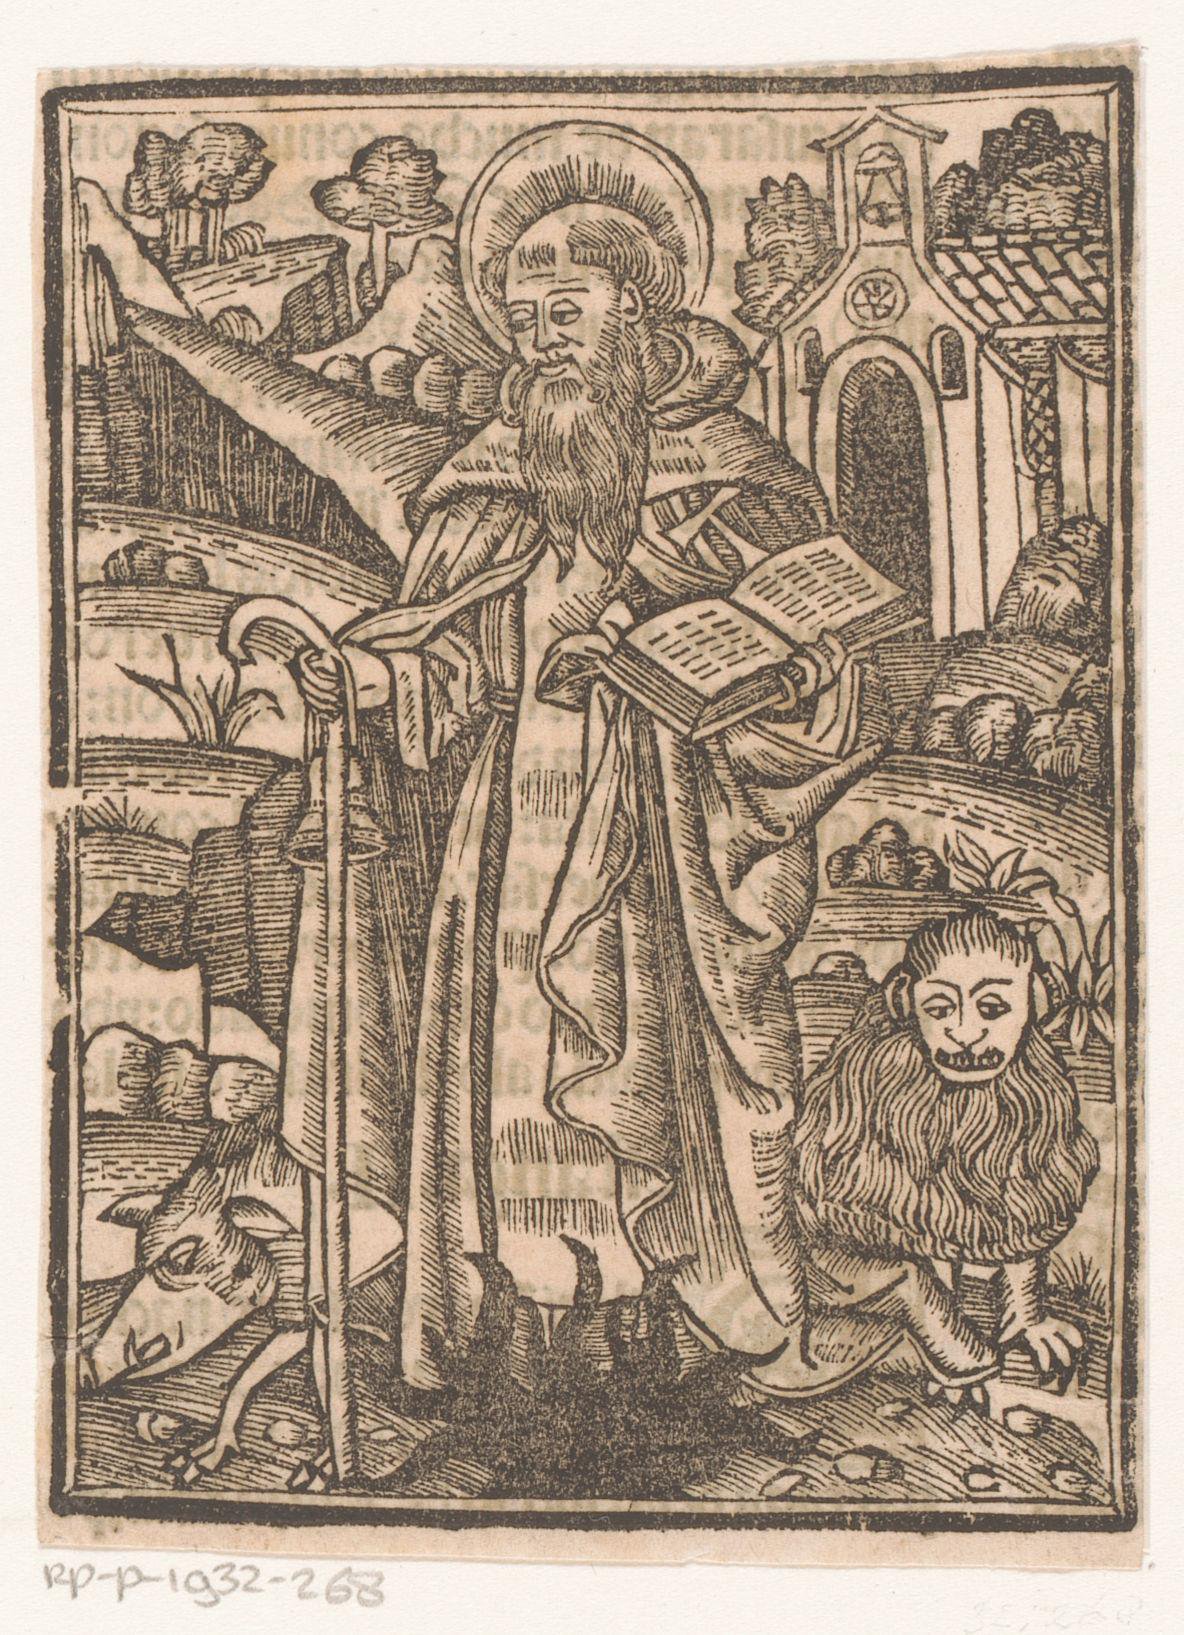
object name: print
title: H. Hieronymus staand met een staf en een open boek naast een leeuw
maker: Anonymous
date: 1550-1649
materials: paper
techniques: letterpress printing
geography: netherlands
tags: the monk and hermit jerome (hieronymus); possible attributes: book, cardinal's hat, crucifix, hour-glass, lion, skull, stone